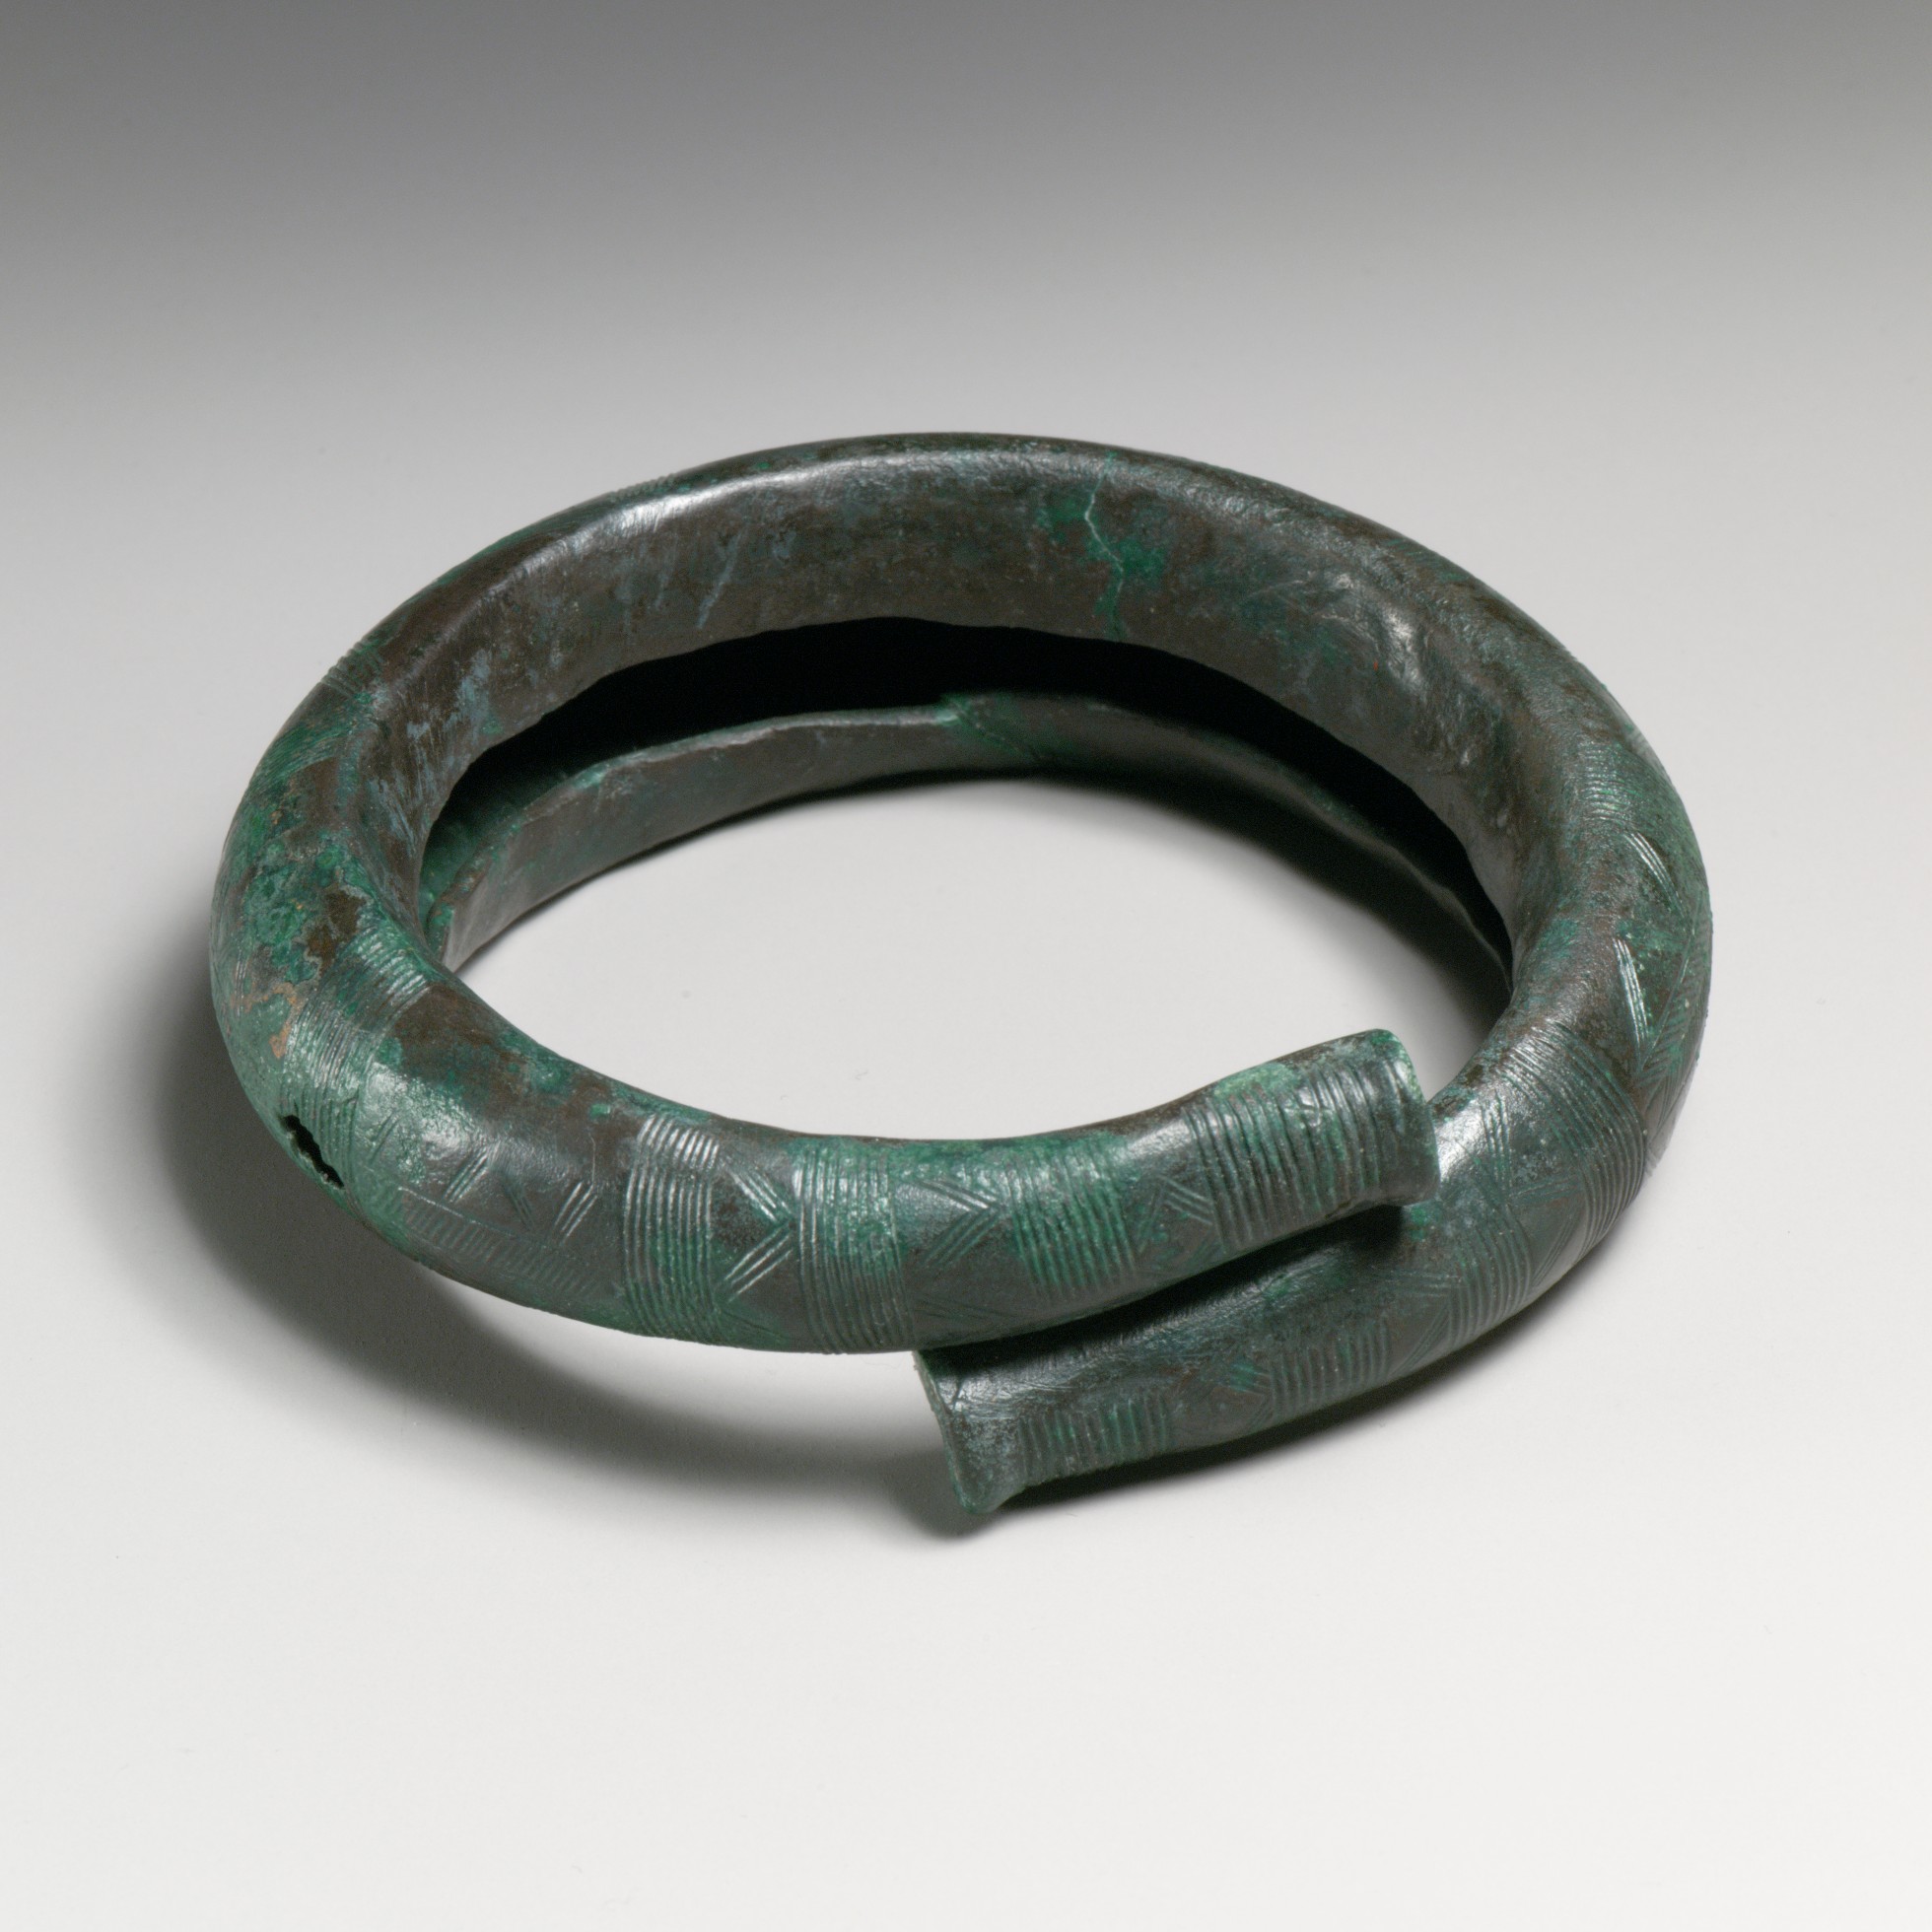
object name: bracelet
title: Bronze bracelet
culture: italic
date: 800-701 BCE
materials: bronze